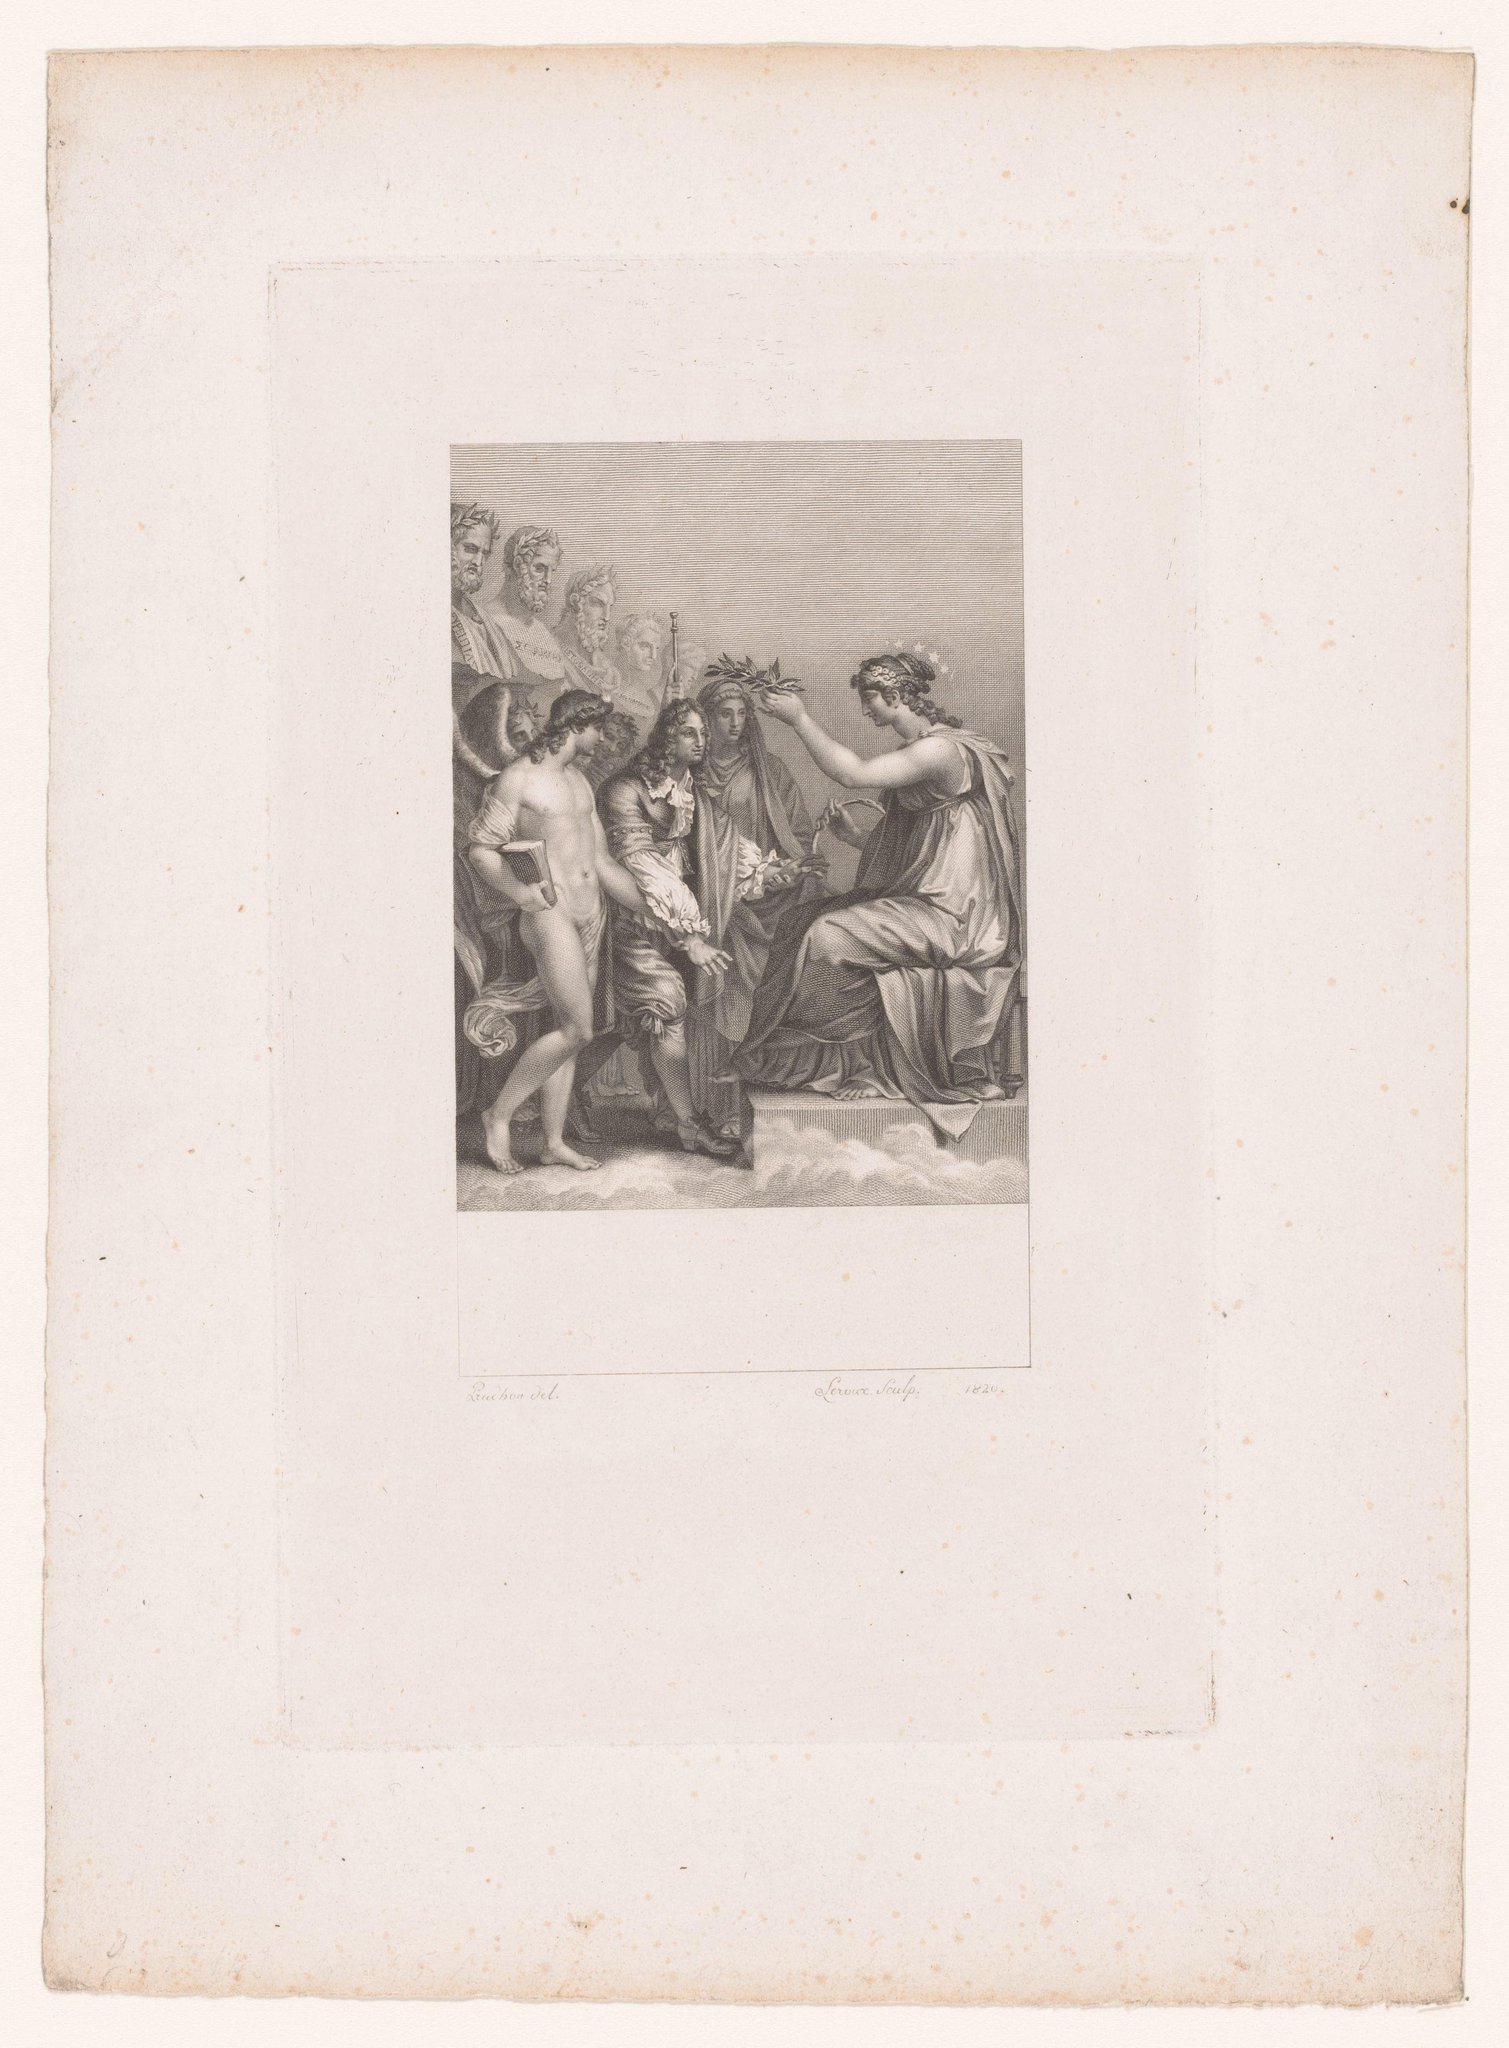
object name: print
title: Apotheose van Jean Racine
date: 1820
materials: paper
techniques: engraving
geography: paris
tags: france, jean racine, historical persons, melpomene (one of the muses); 'melpomene' (ripa), immortality, imperishableness; 'immortalità' (ripa), 'genio' (ripa)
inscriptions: collector's mark: Lugt 2228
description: Prent uit: Racine, Jean. Oeuvres complètes de Jean Racine. Parijs: Lefèvre, 1820.